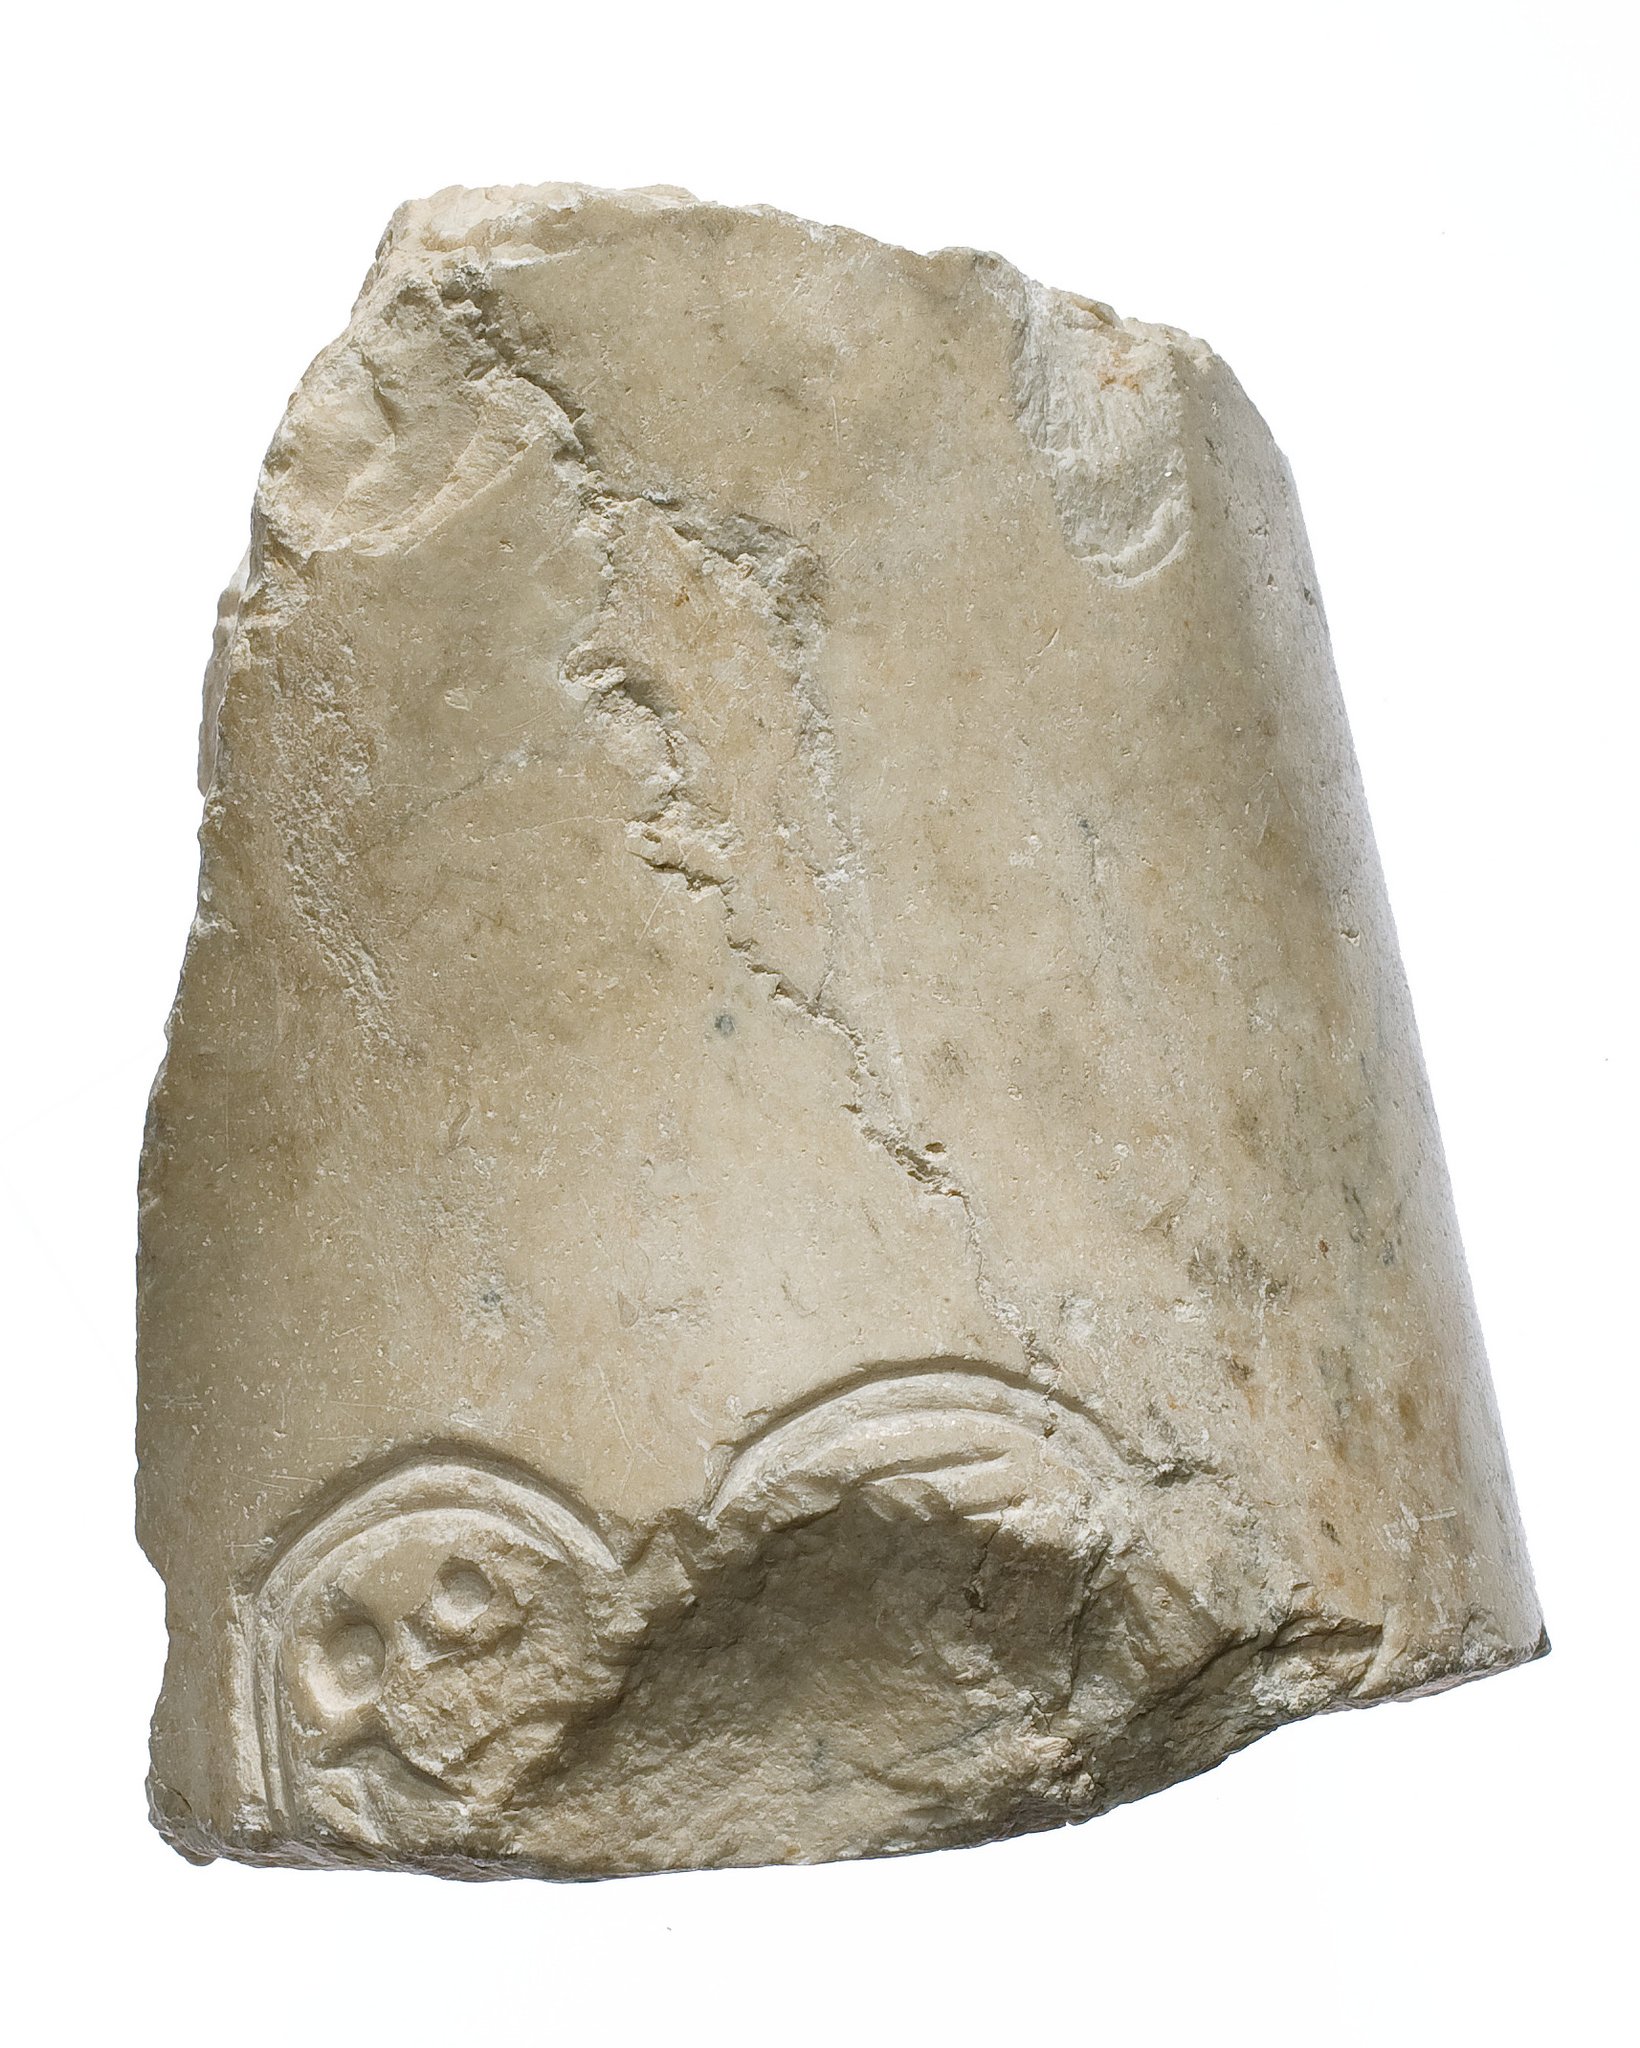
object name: arm at shoulder, aten cartouch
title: Arm, left shoulder with Aten cartouche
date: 1353-1336 BCE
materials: limestone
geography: egypt